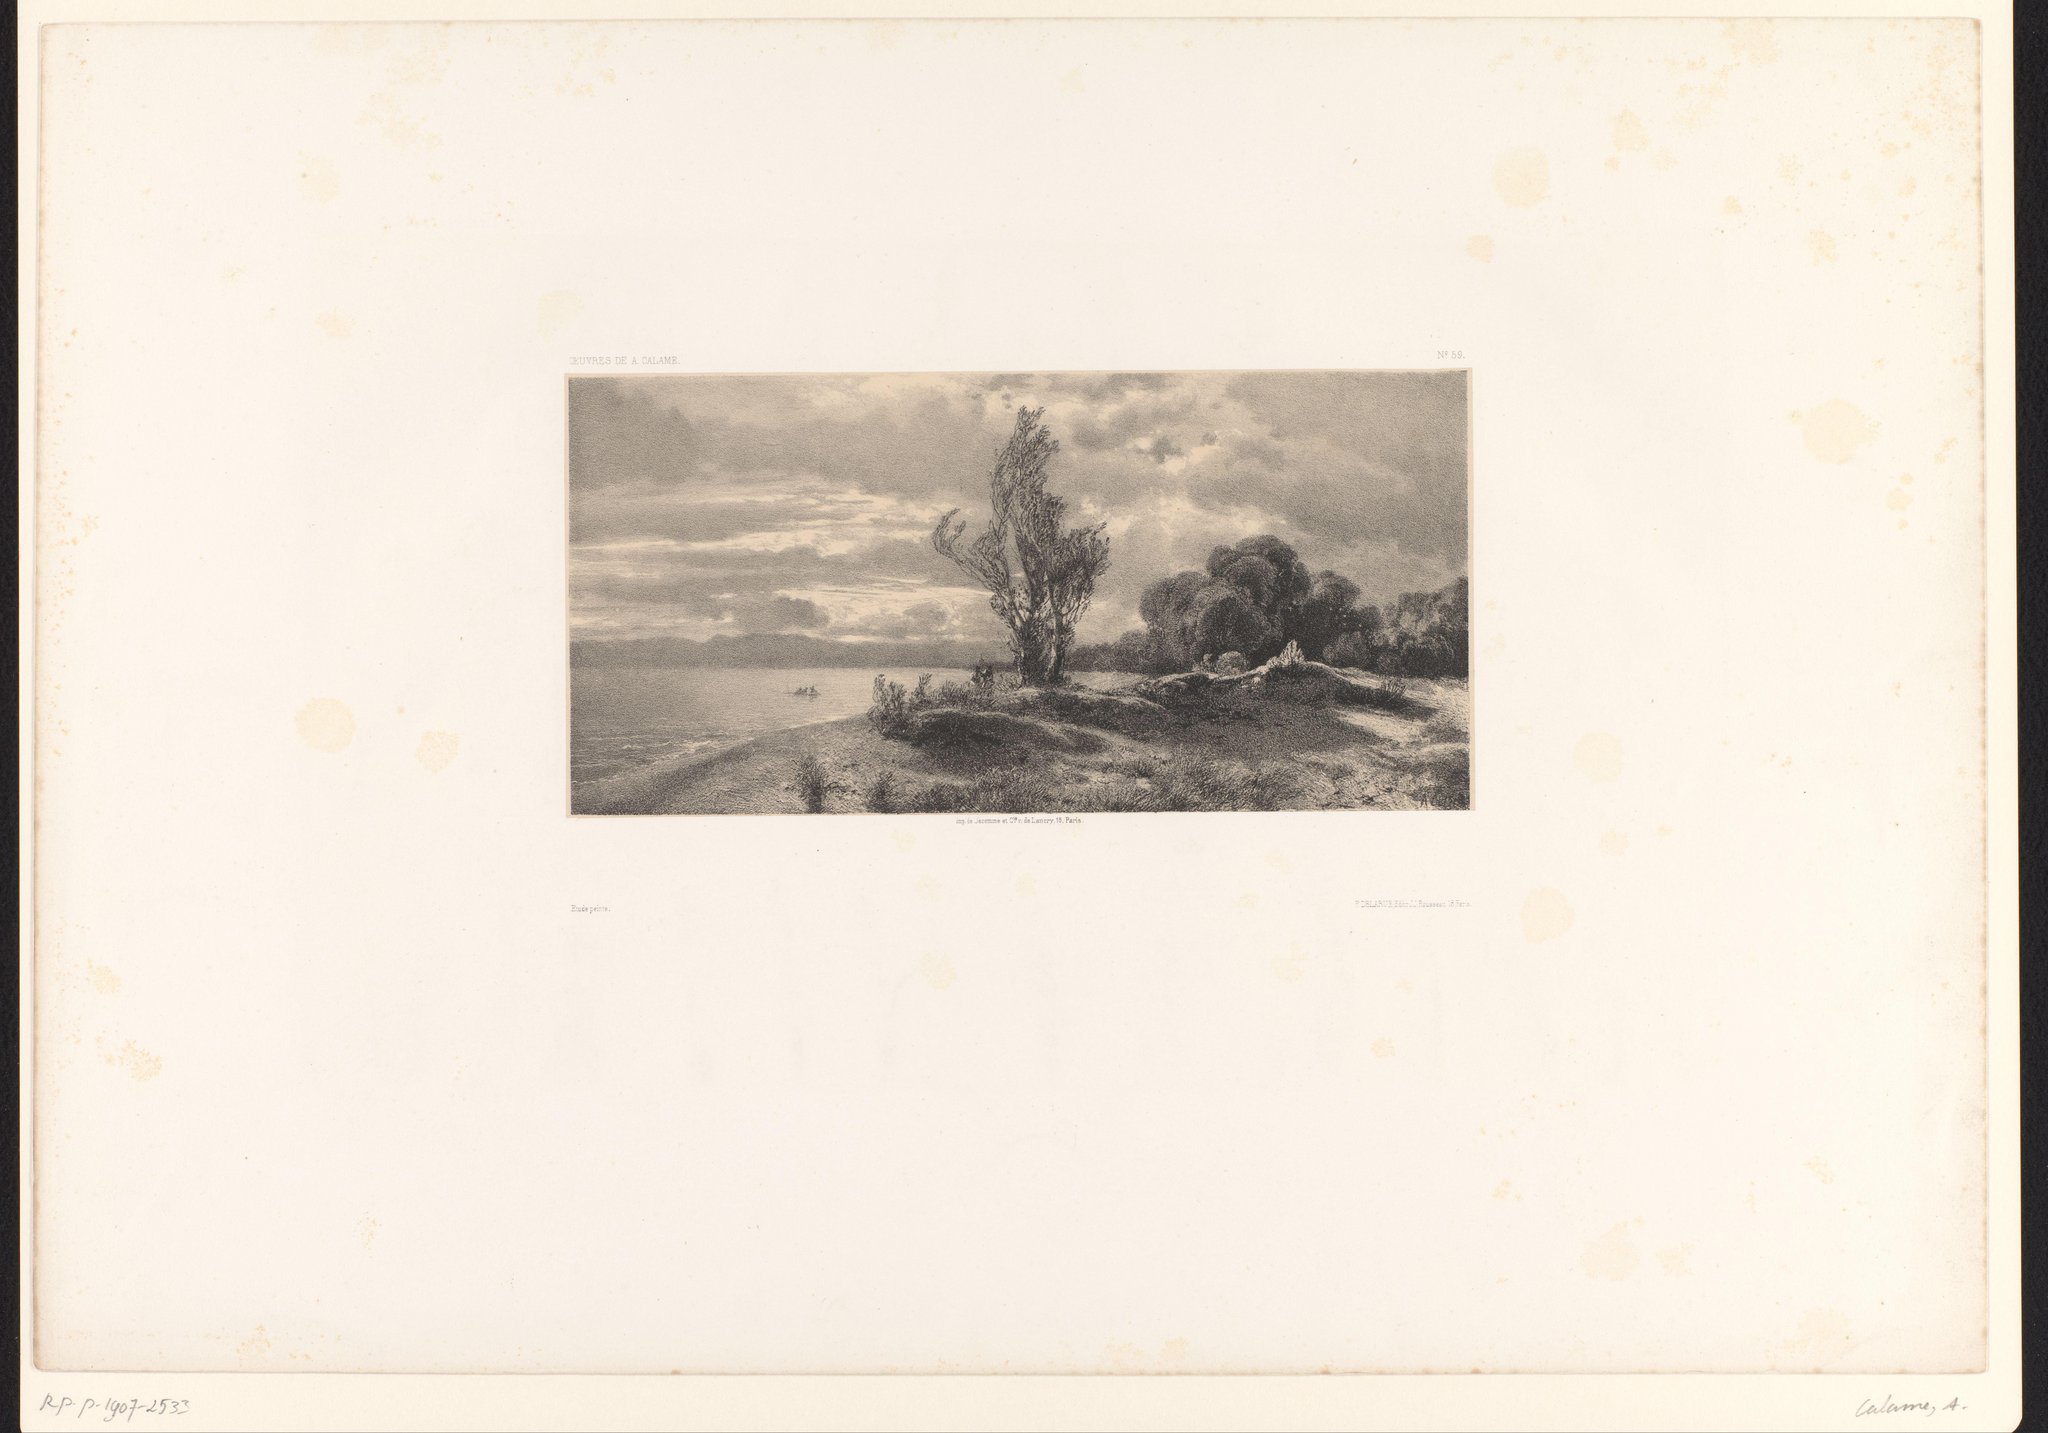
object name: print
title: Berglandschap met boom aan de oever van een meer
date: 1852-1855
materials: paper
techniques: lithograph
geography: paris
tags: trees, mountains (+ landscape with figures, staffage), coast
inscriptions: collector's mark: Lugt 2228a